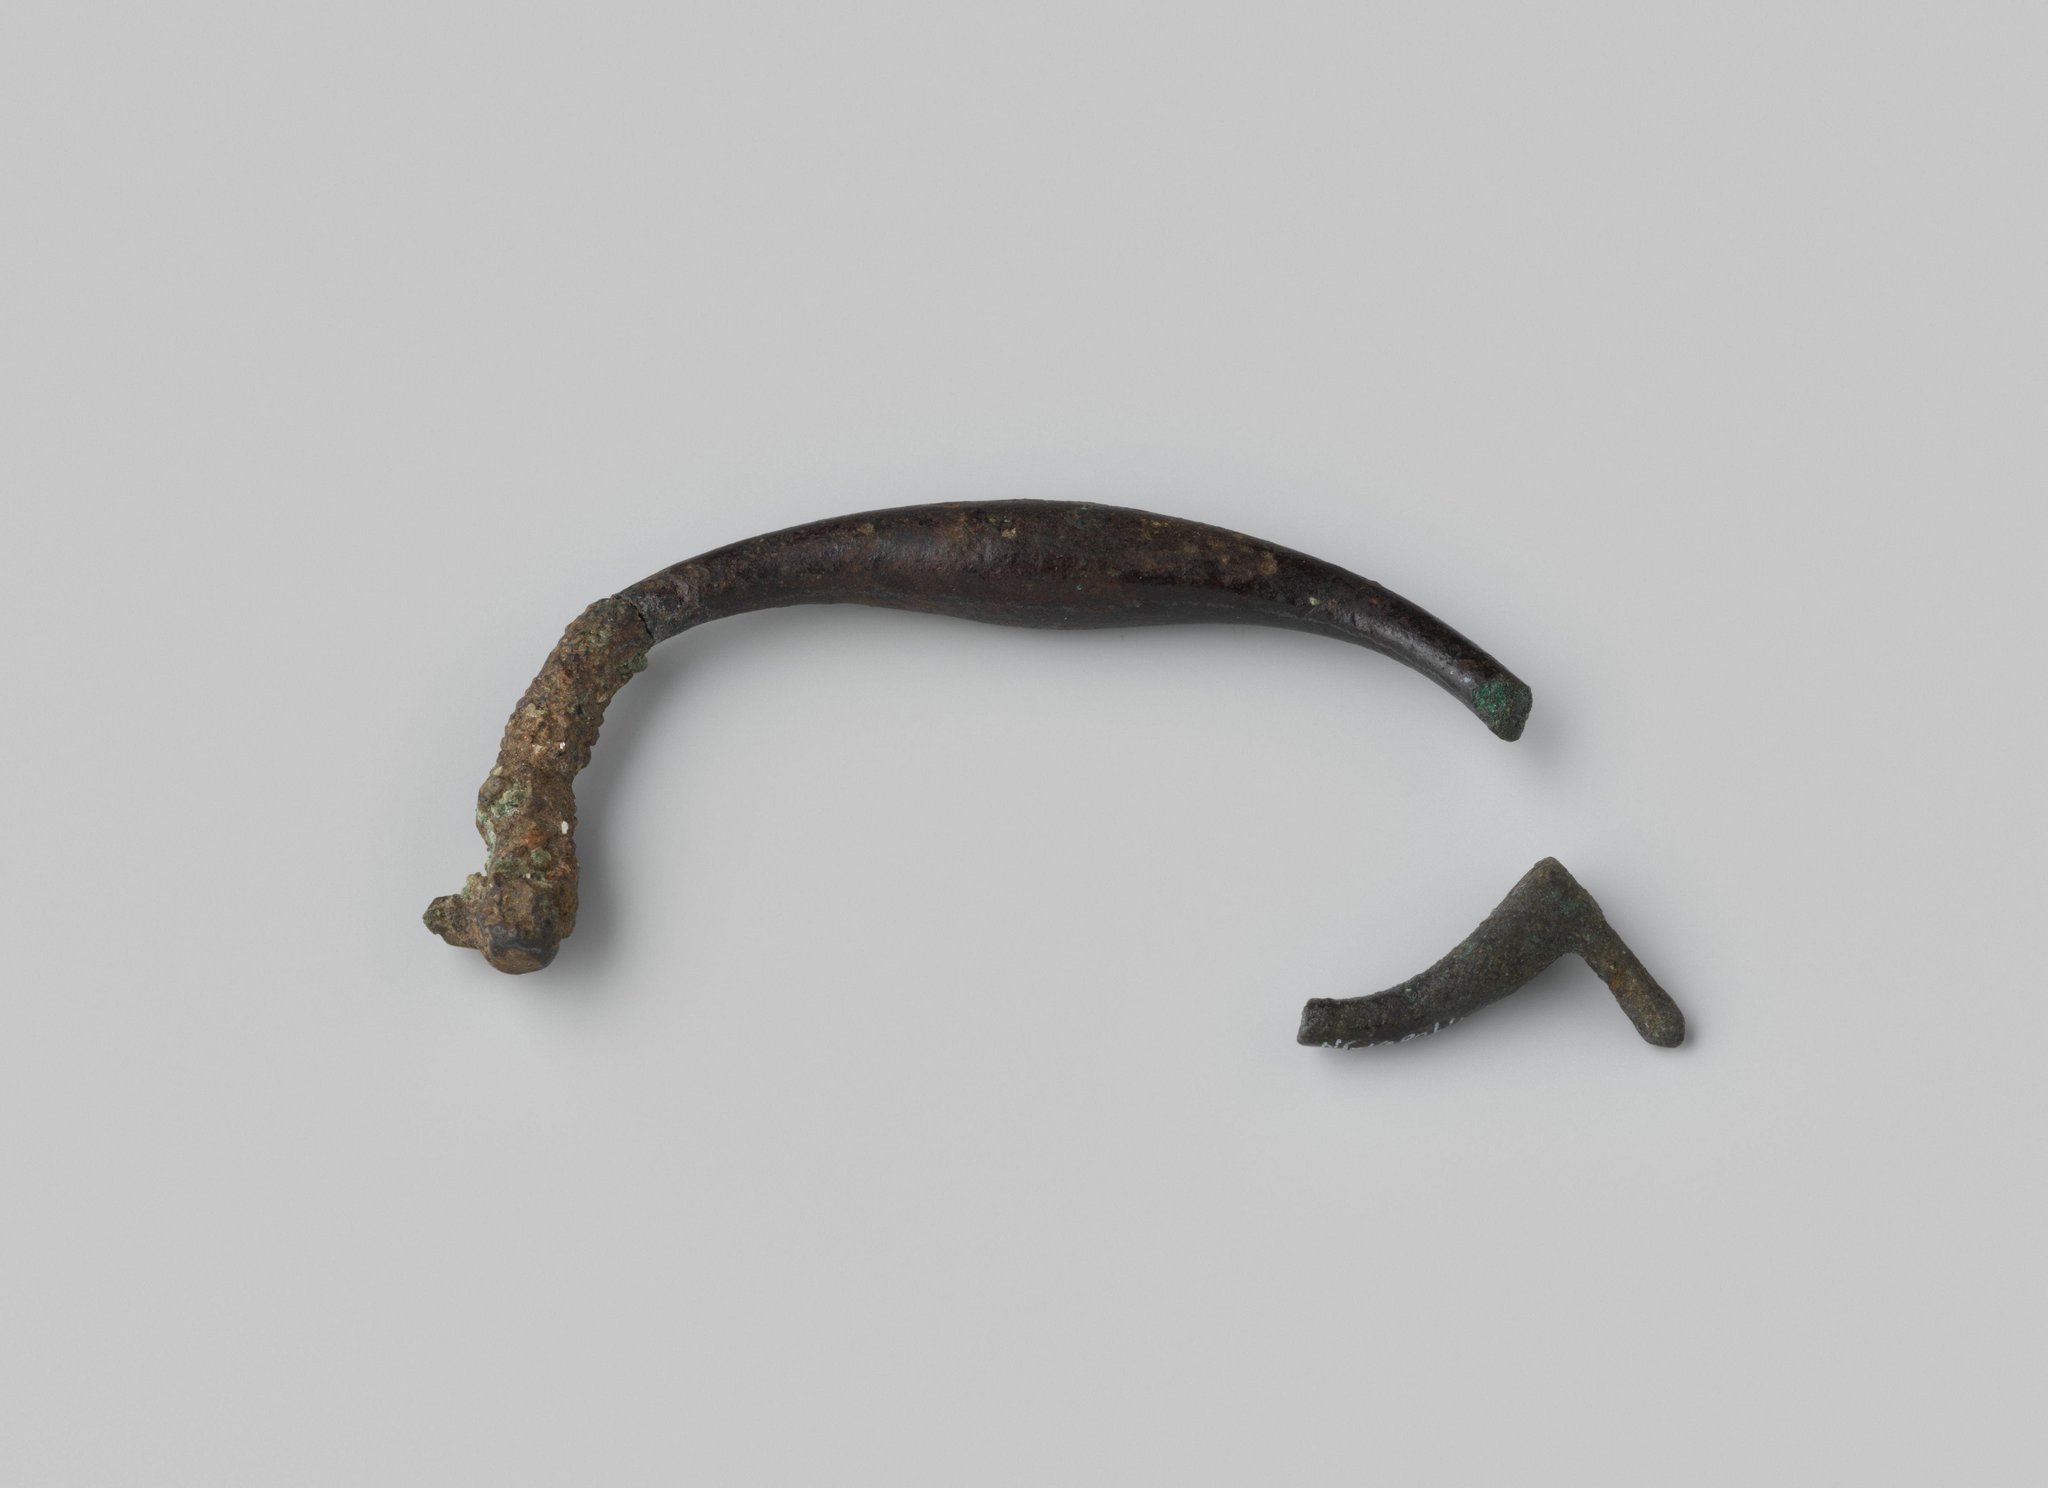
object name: bail handle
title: Beugelhandvat uit het wrak van de Oost-Indiëvaarder Hollandia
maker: Anonymous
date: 1700-1743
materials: copper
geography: netherlands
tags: verenigde oostindische compagnie, hollandia (schip), annet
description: Fittings, handles, bail handle; fragm, id. NG 1979-226H2992, eroded.